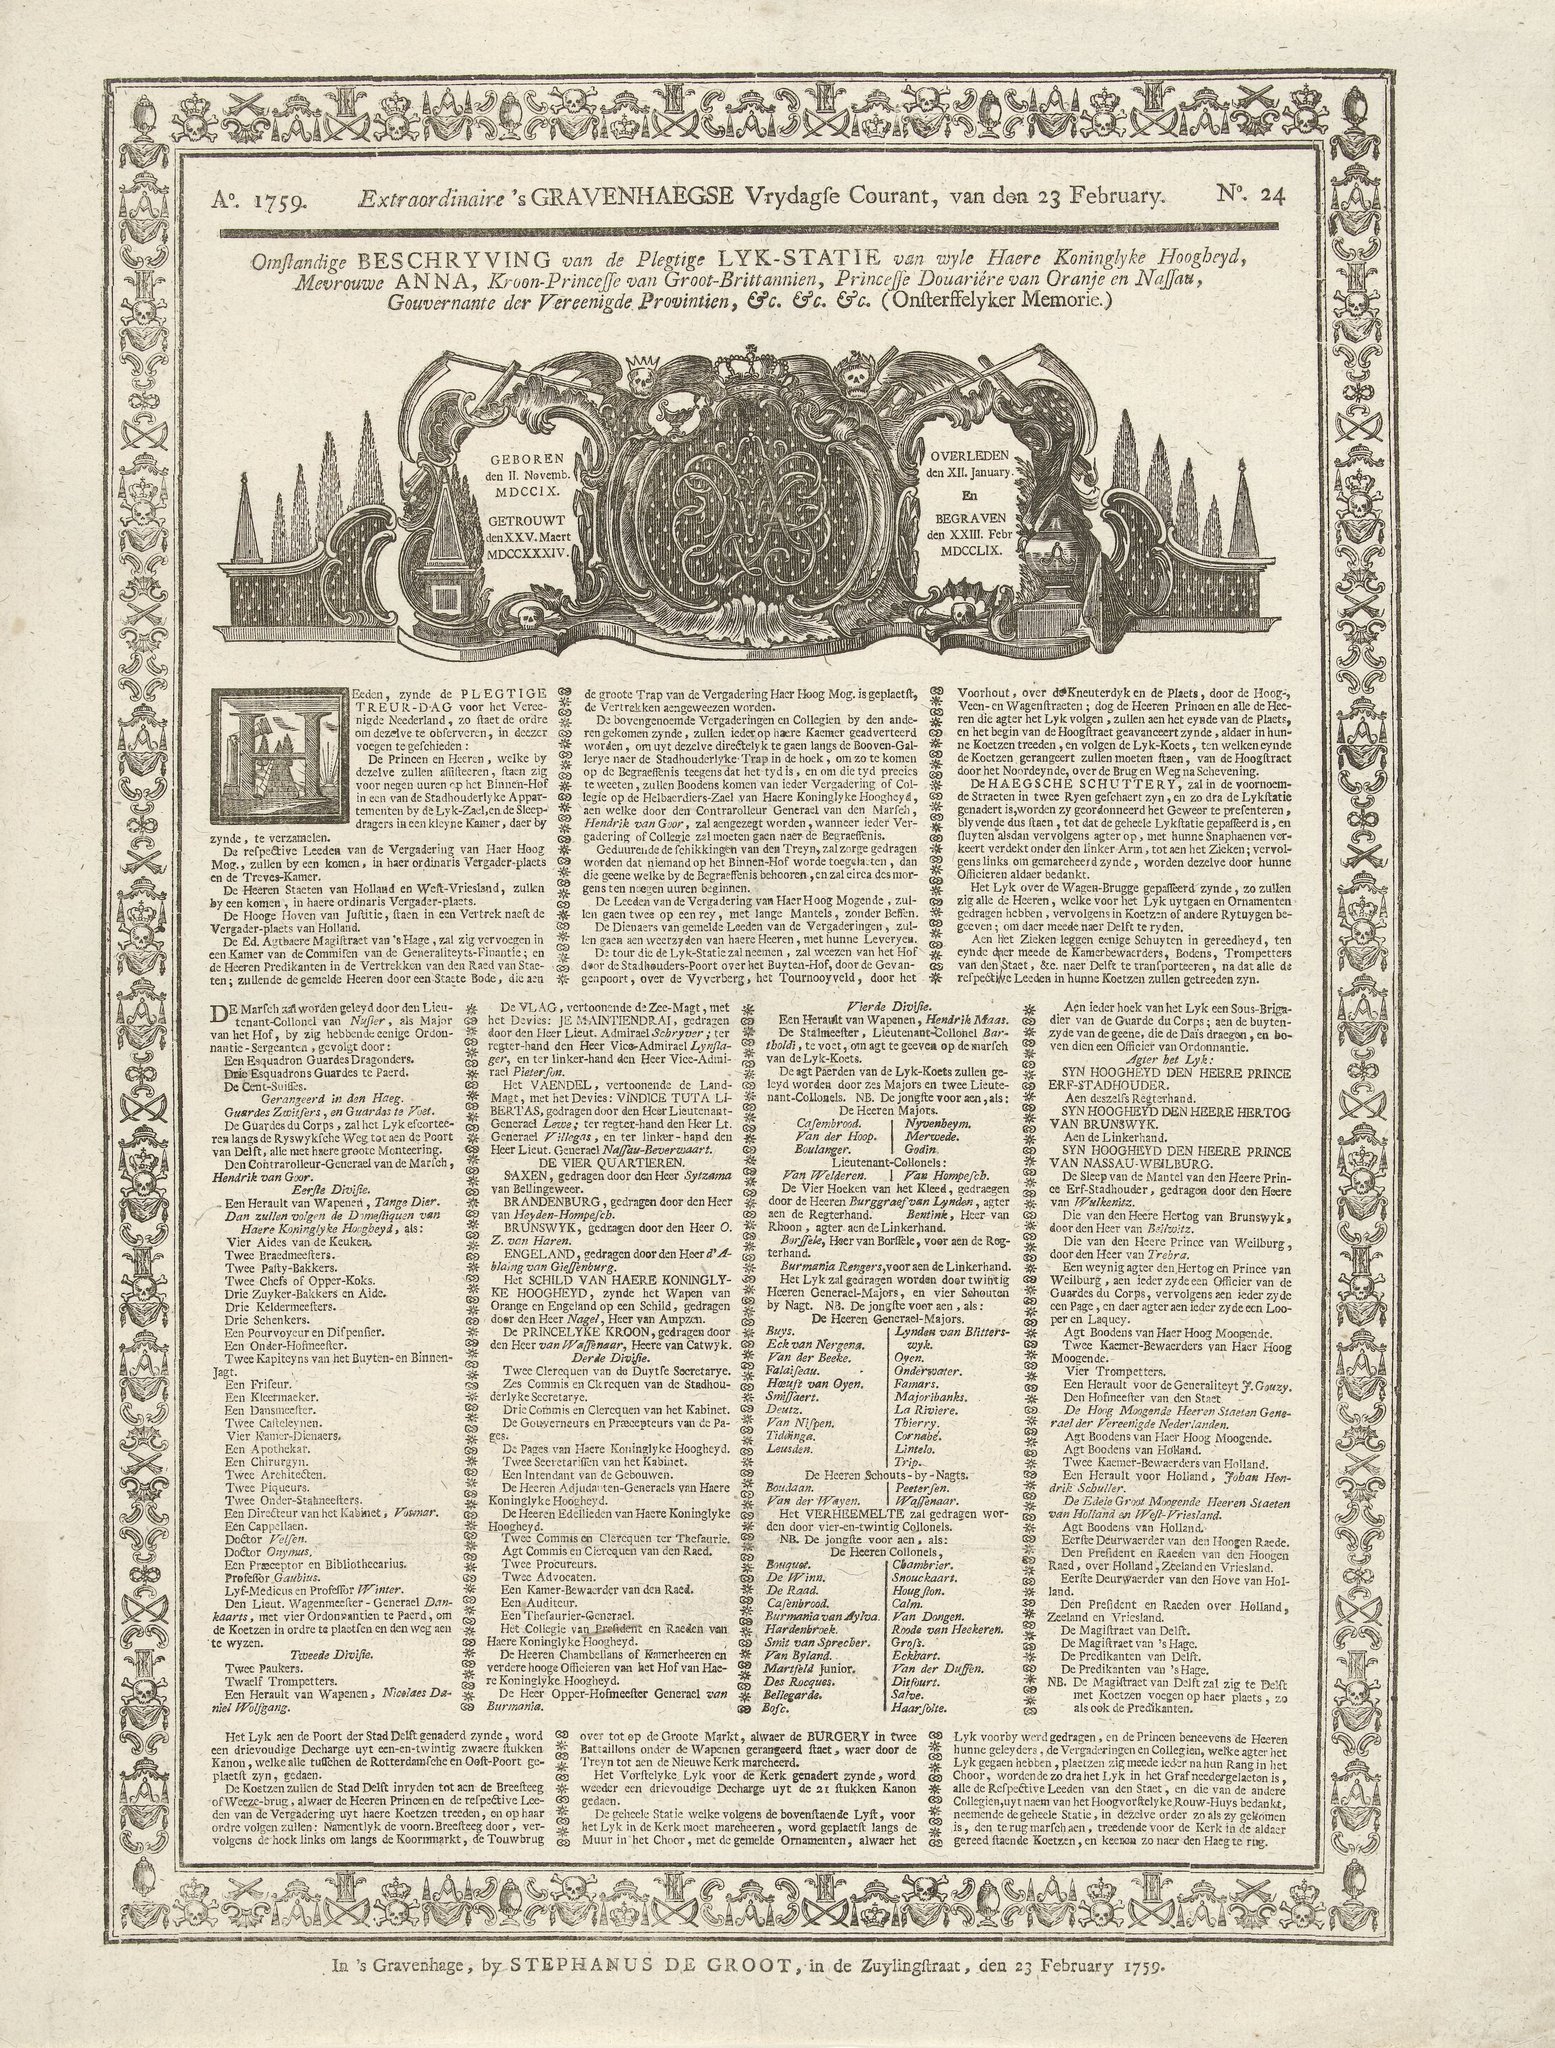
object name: newspaper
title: Extra editie van de 's Gravenhaegse Vrijdagse Courant over de lijkstatie van prinses Anna, 1759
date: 1759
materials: paper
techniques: letterpress printing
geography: northern netherlands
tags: anna van hannover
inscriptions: collector's mark: Lugt 2228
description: Extra editie van de 's Gravenhaegse Vrijdagse Courant van 23 februari 1759 No. 24. Met een beschrijving van de lijkstatie van prinses Anna op 23 februari 1759. Bovenaan een allegorisch vignet met het monogram van de prinses. Blad in een ornamentele rand met doodskoppen, gedoofde fakkels en andere symbolen van de dood.